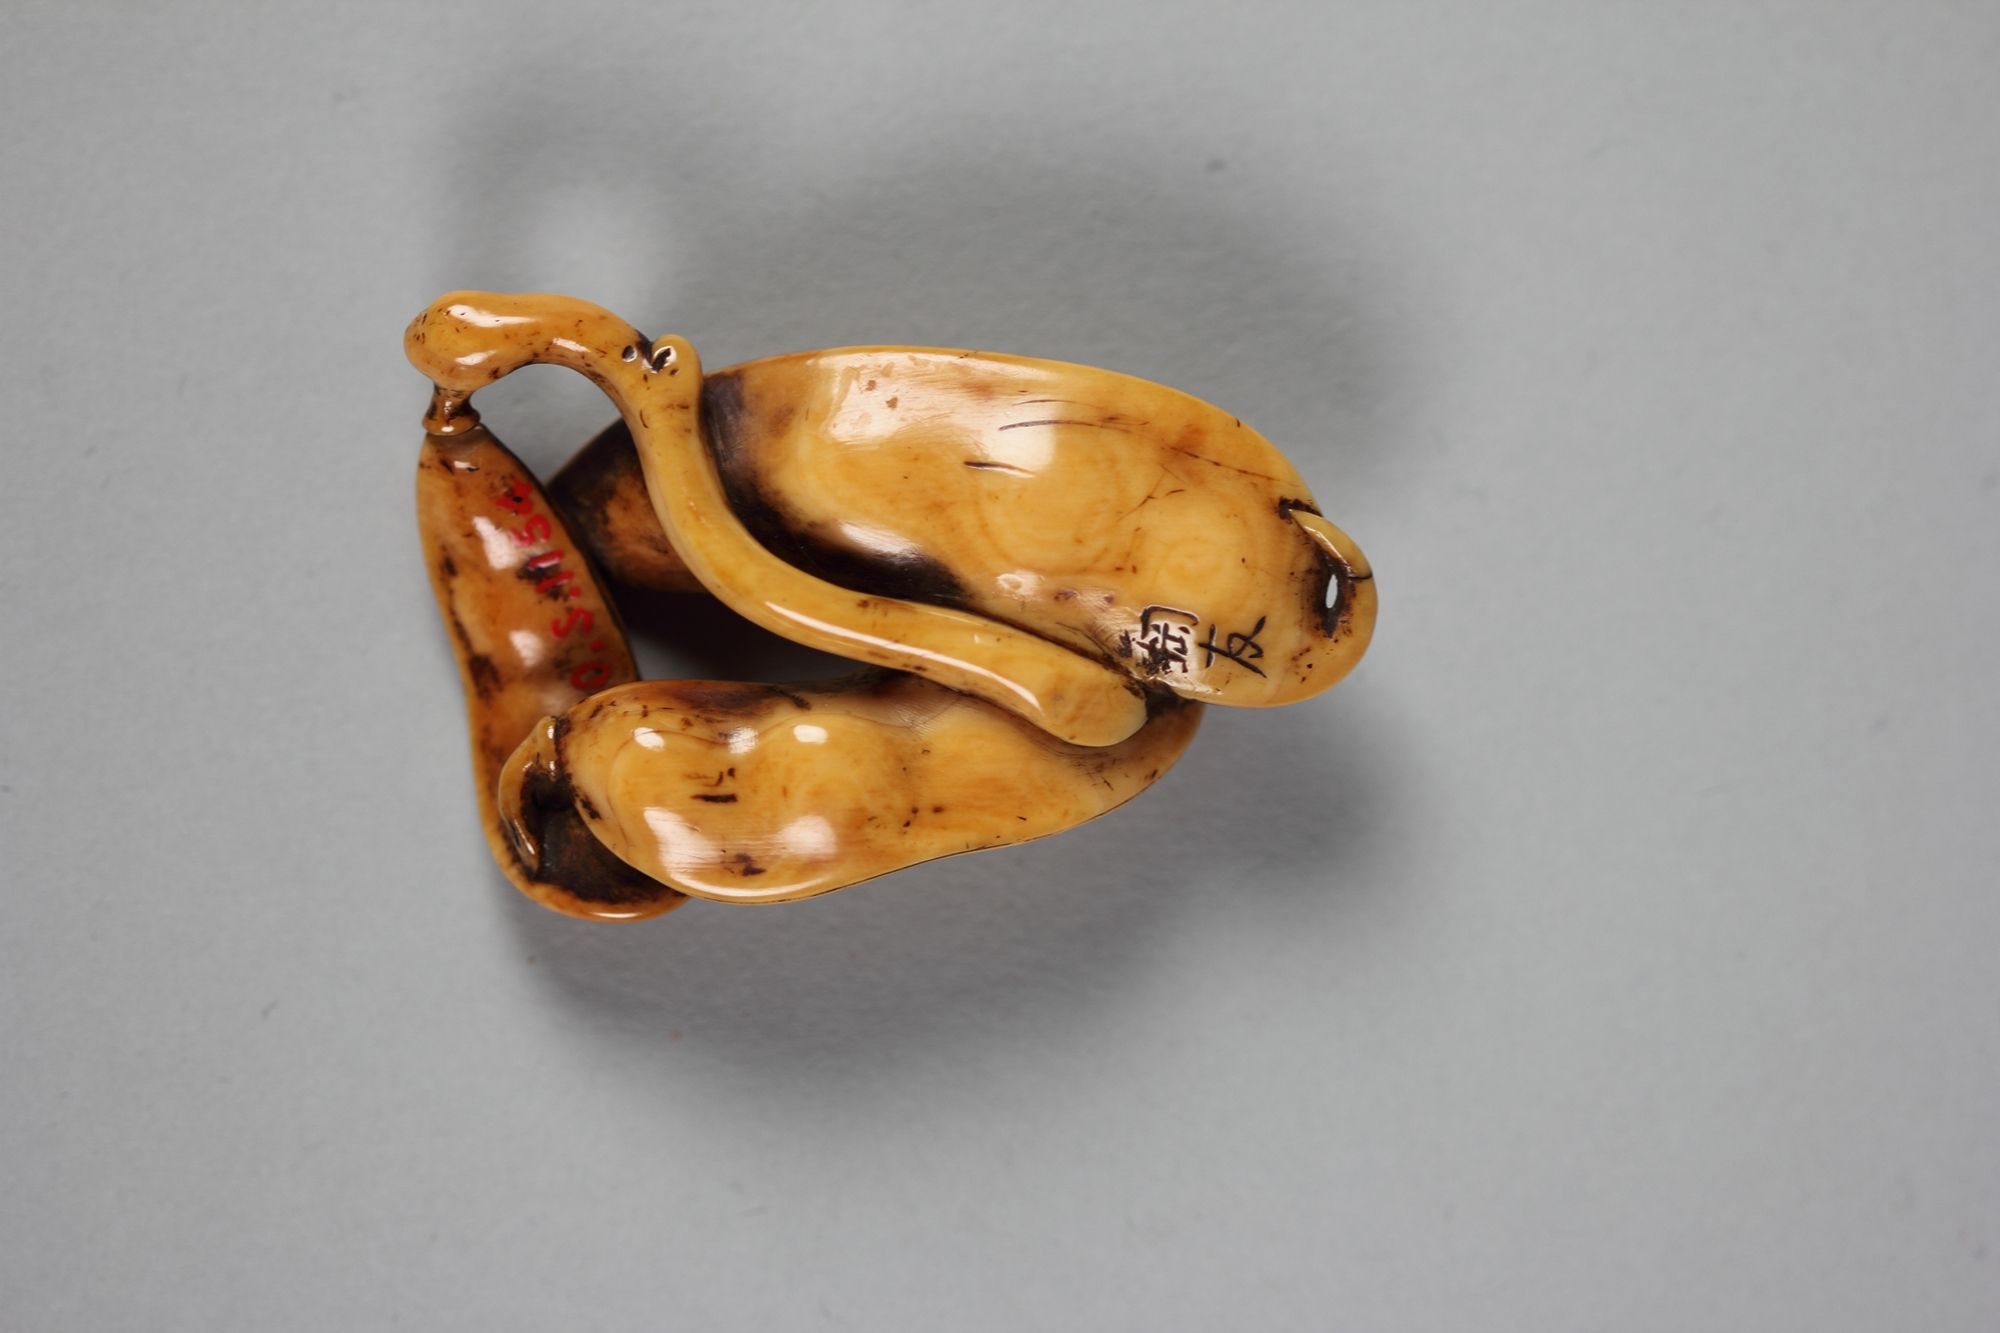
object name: netsuke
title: Edamame (Soy Beans)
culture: japanese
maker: okatomo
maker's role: artist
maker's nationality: japanese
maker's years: 1767-1833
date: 1767-1833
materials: ivory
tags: vegetables